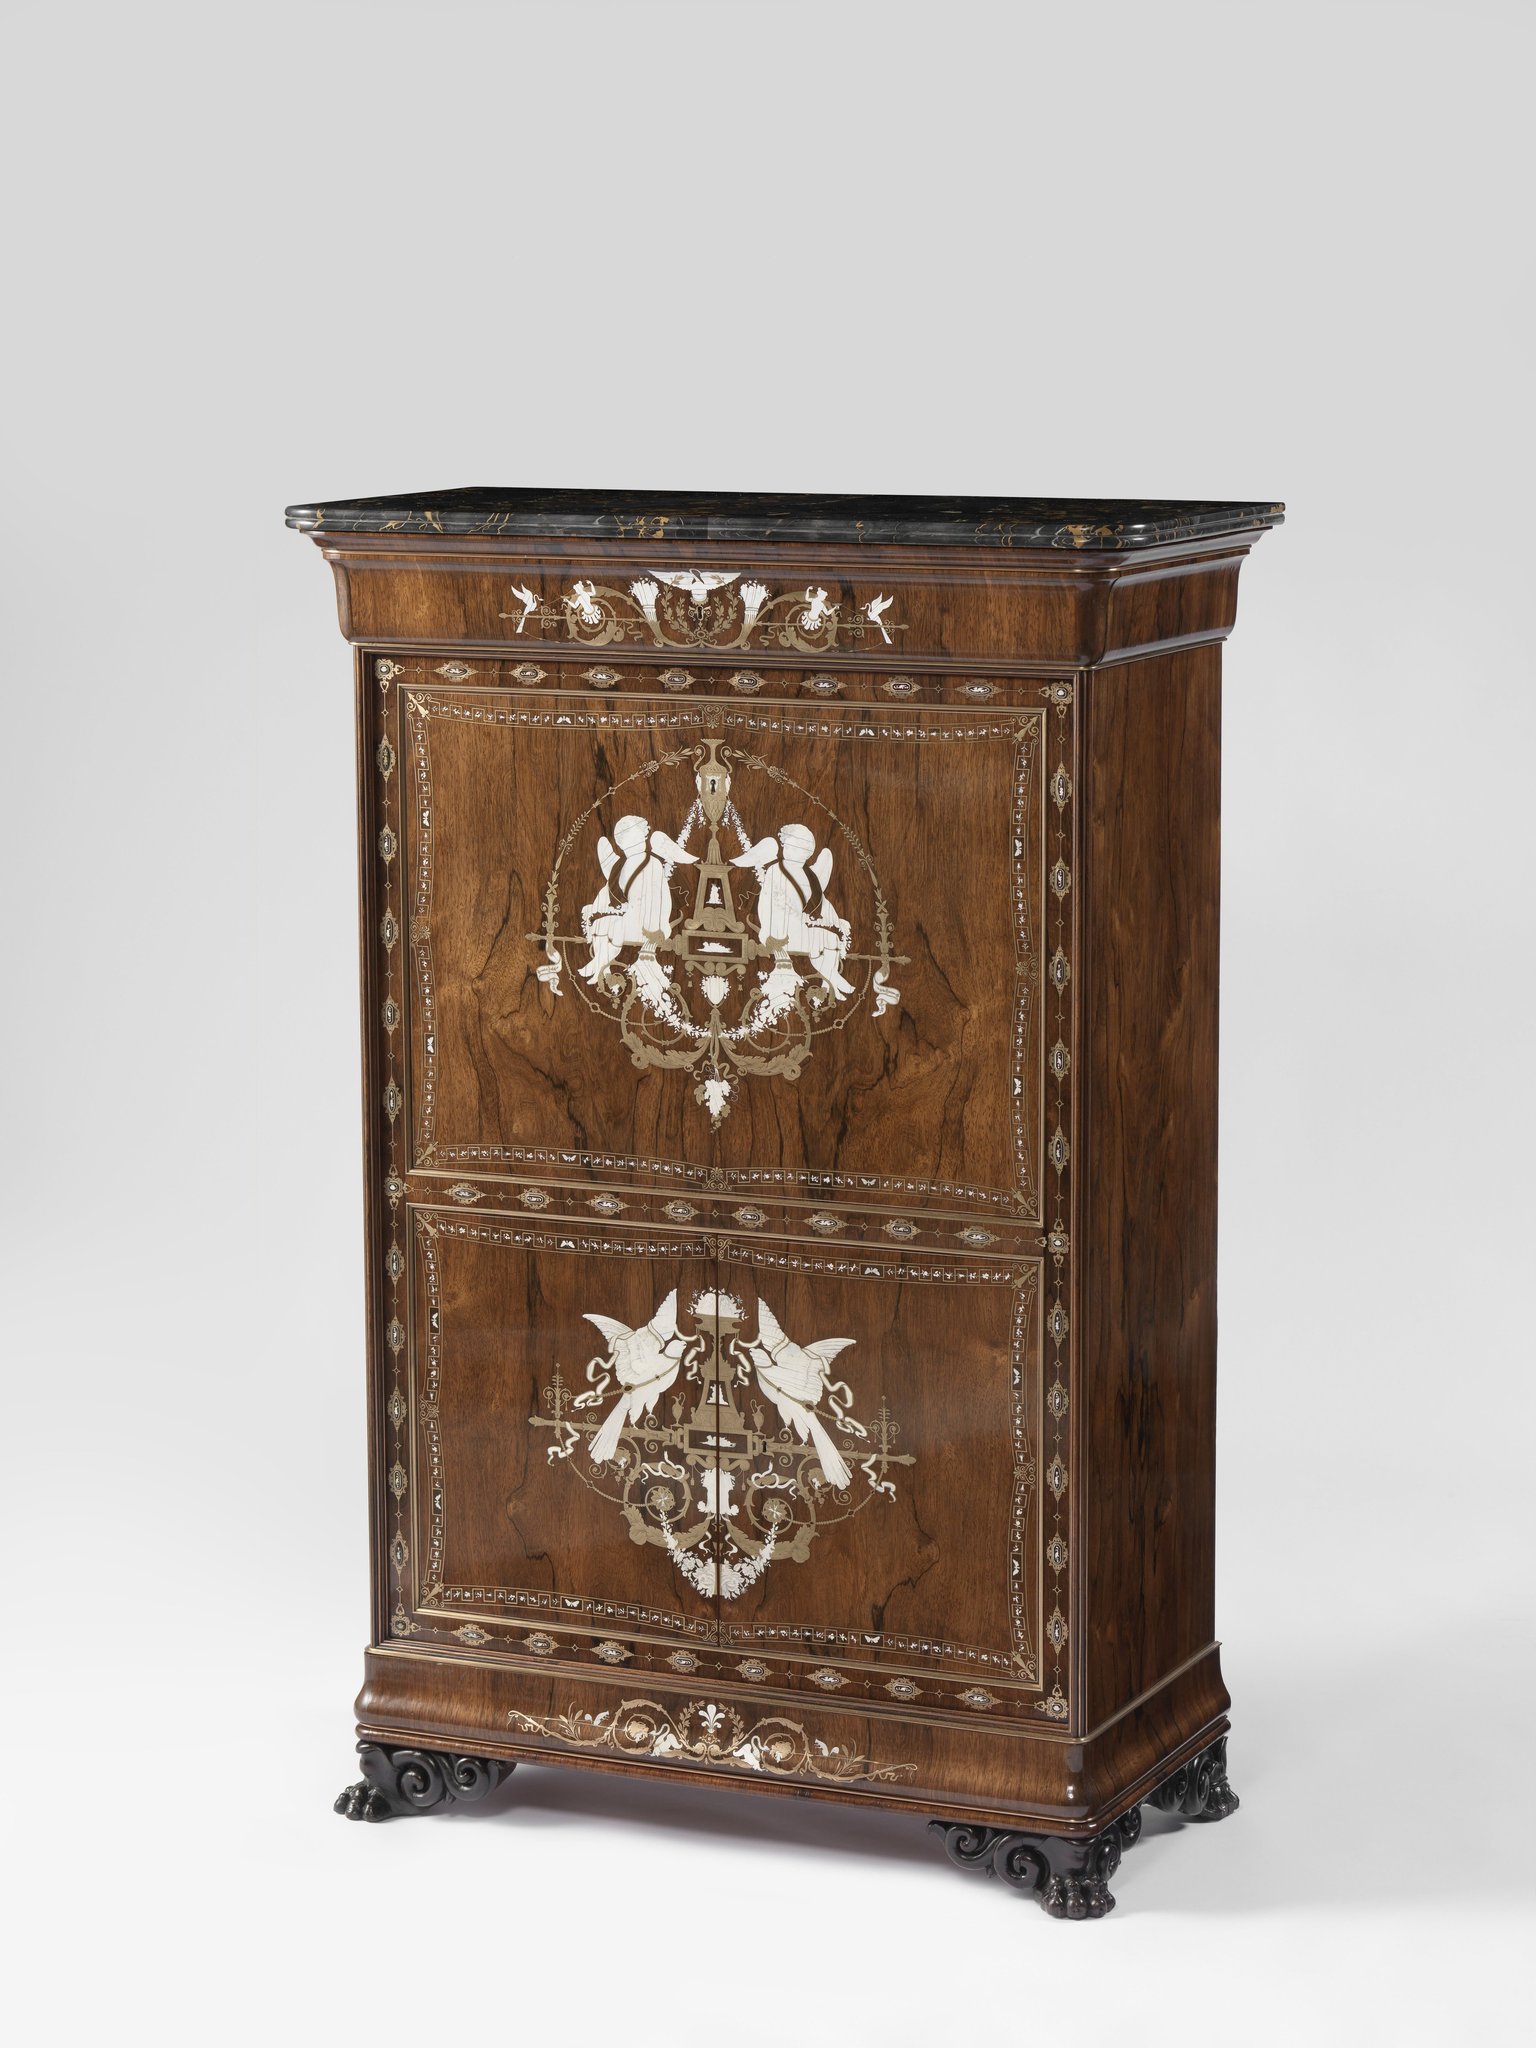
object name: secretary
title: Secretary, commode and table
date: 1834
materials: brass, copper, ivory, wood, marble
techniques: marquetry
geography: paris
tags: ornaments ~ art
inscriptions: signature: ‘Friedrich Frickhinger/ Ebenist Aus/ Nördlingen/ Hat diesen Sekerathäre/ Gemacht bei Meister/ Blechmidt in Jahr 1834.’, inscription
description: German-born Blechschmidt worked for leading Paris cabinetmakers and specialized in colourful marquetry (inlaid work) in various materials. He used an Italian Renaissance style for the marquetry here. Friedrich Frickhinger, one of his pupils and also a German active in Paris, made the furniture. He placed his signature and the date, 1834, on the inside of the secretary.